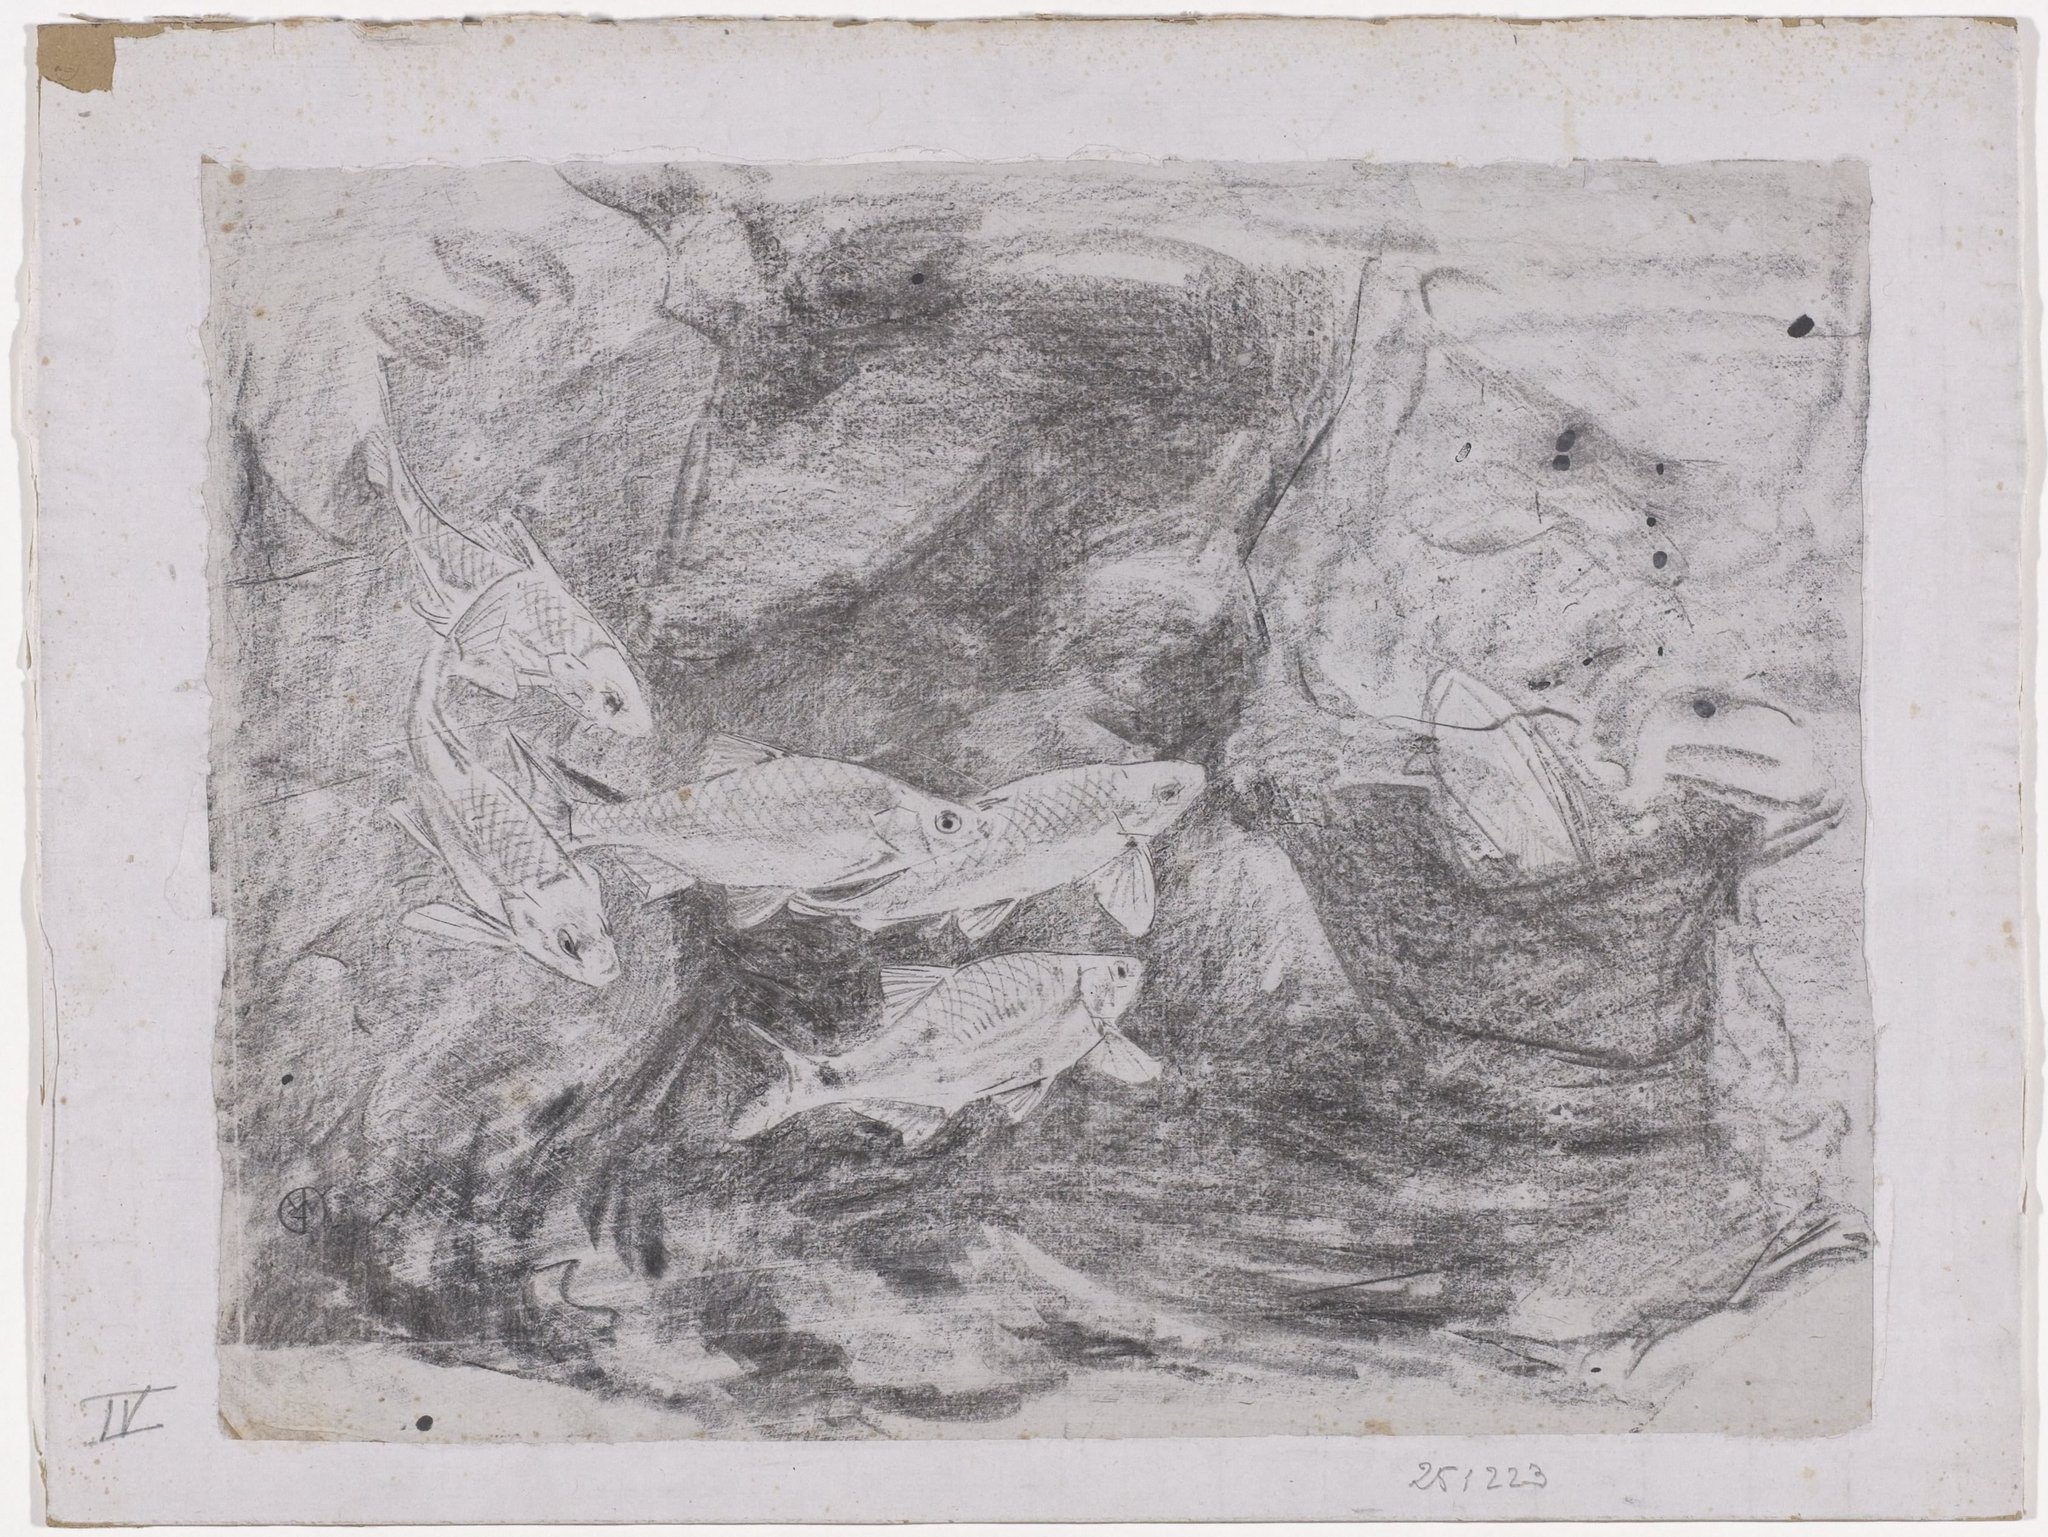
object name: drawing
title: Studieblad met goudwinden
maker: gerrit willem dijsselhof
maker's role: designer, draughtsman, print maker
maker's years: 1866-1924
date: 1876-1924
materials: charcoal, paper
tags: fishes